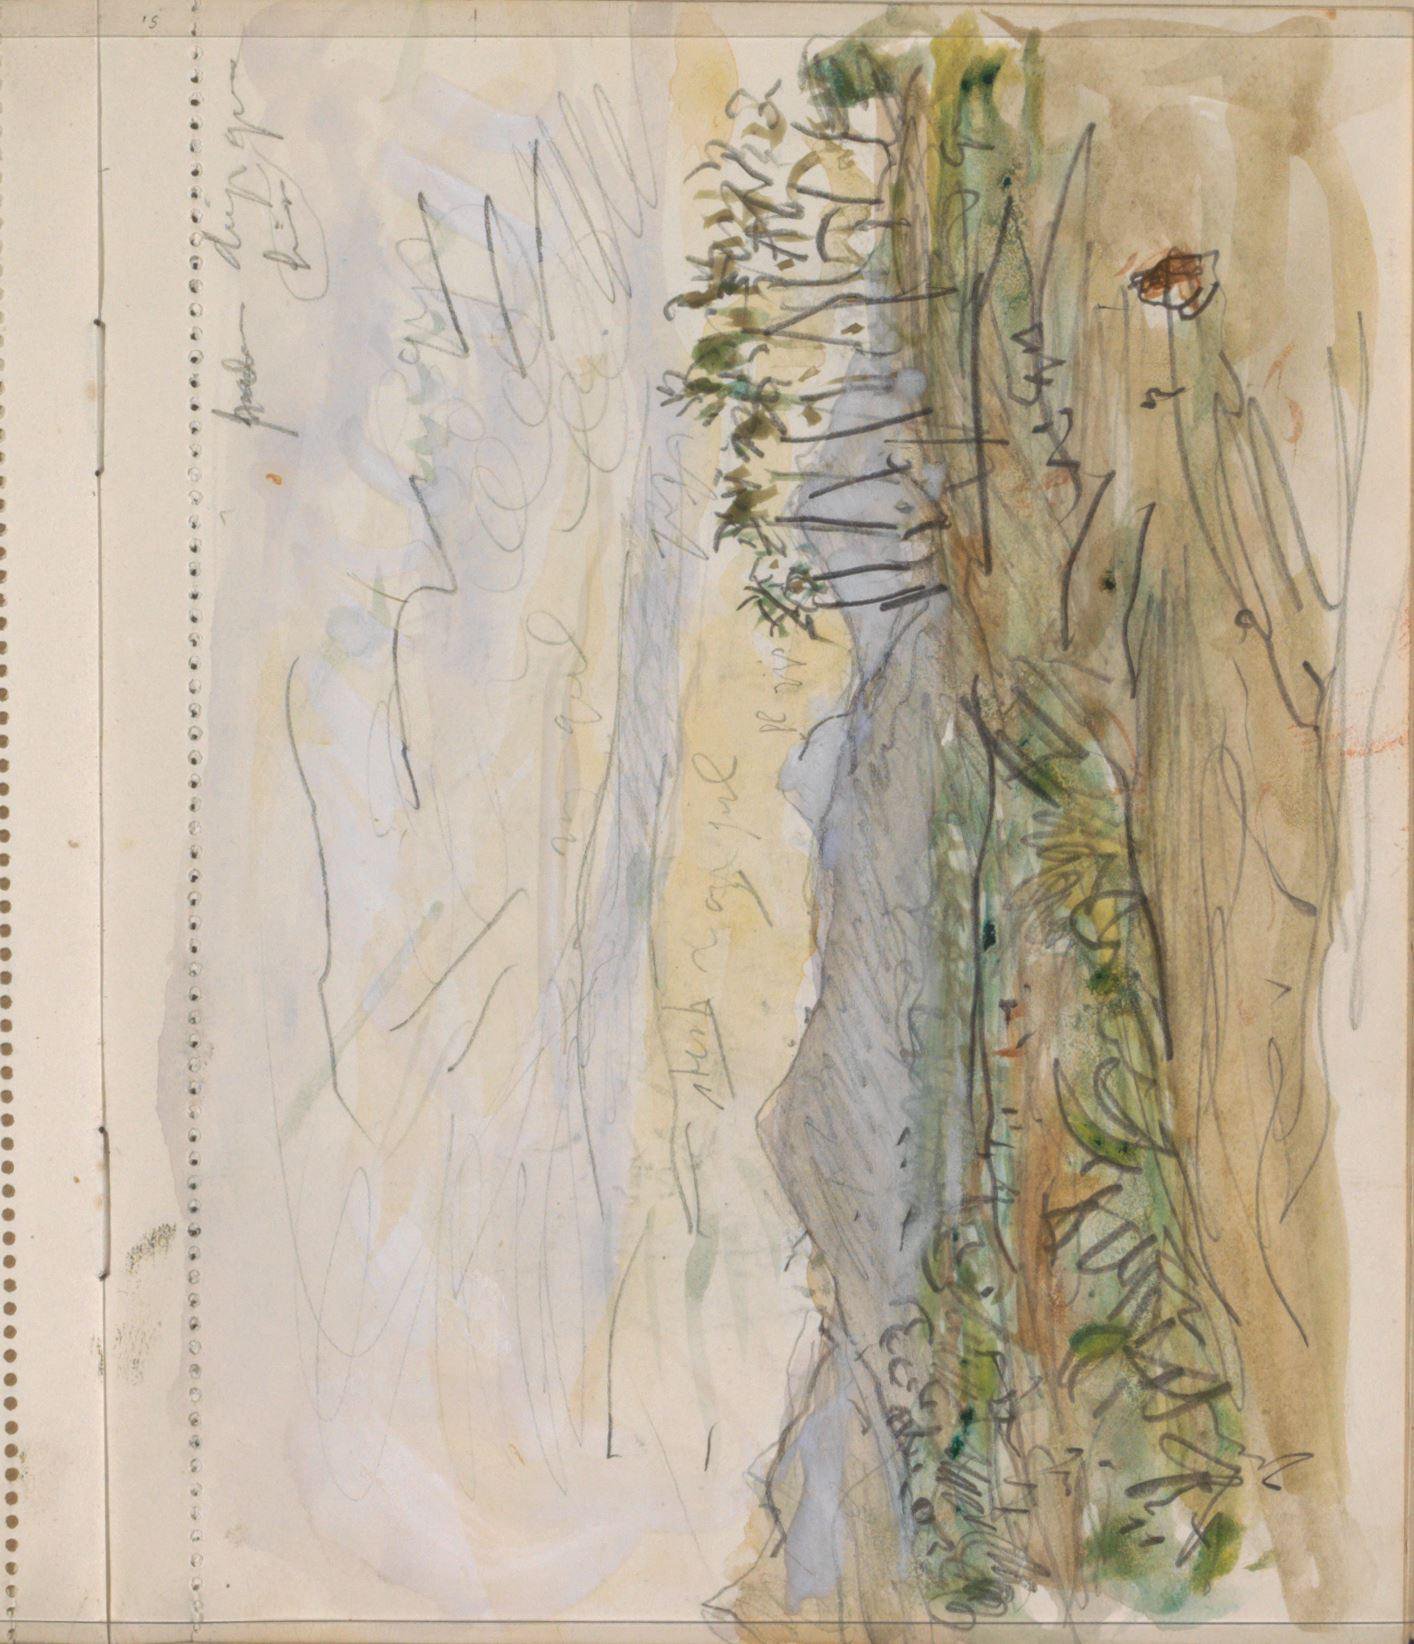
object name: sketchbook leaf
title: Heuvellandschap met sawa's en palmbomen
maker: marius bauer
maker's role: draughtsman, print maker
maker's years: 1867-1932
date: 1925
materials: paper, pencil, watercolor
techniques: brush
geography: java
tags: low hill country, sawahs, rice paddies, trees: palm-tree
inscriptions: kleurnotitie, handgeschreven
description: Pagina 15 uit een schetsboek met 67 bladen.